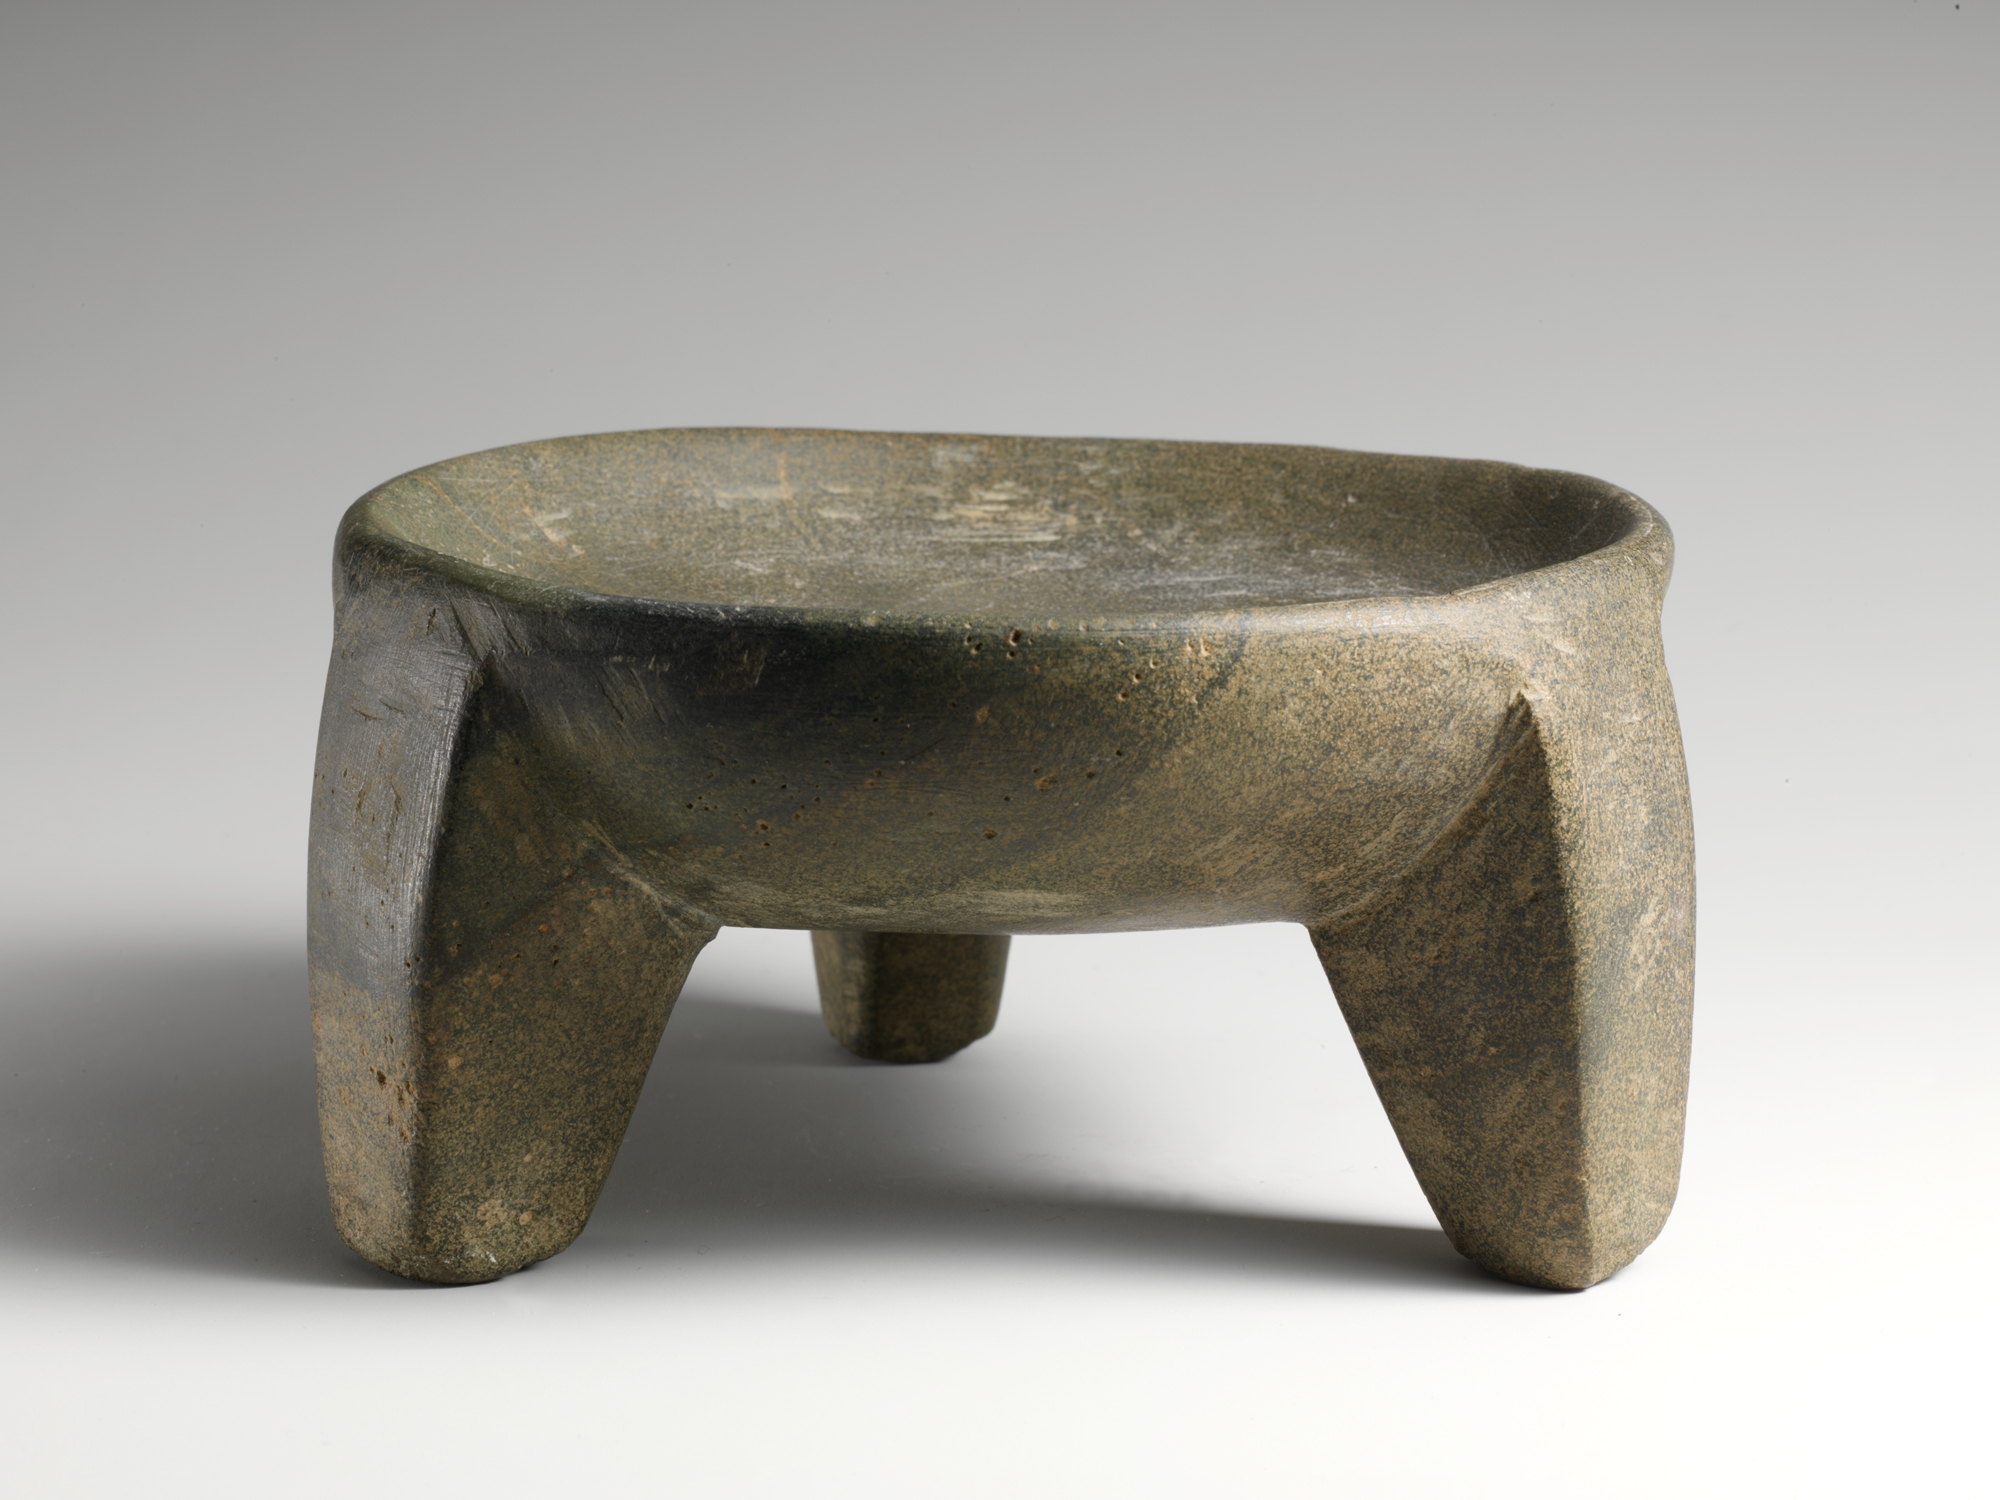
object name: mortar, three legged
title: Chlorite mortar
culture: cypriot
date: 1600-700 BCE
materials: mineral